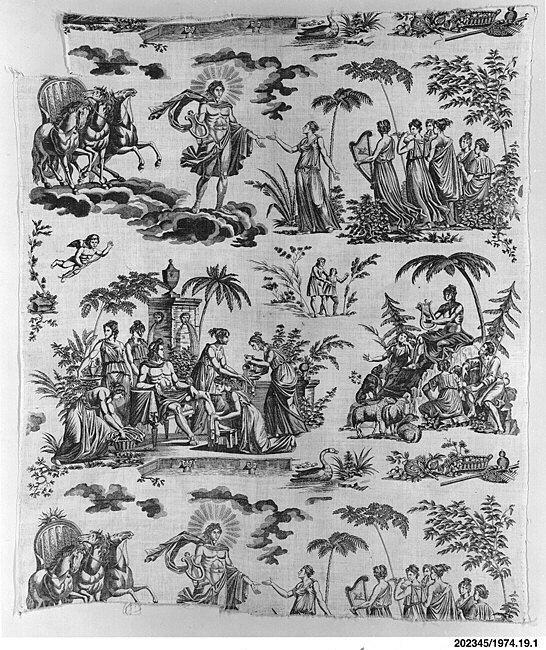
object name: breadth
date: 1701-1800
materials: cotton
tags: men,women,horses